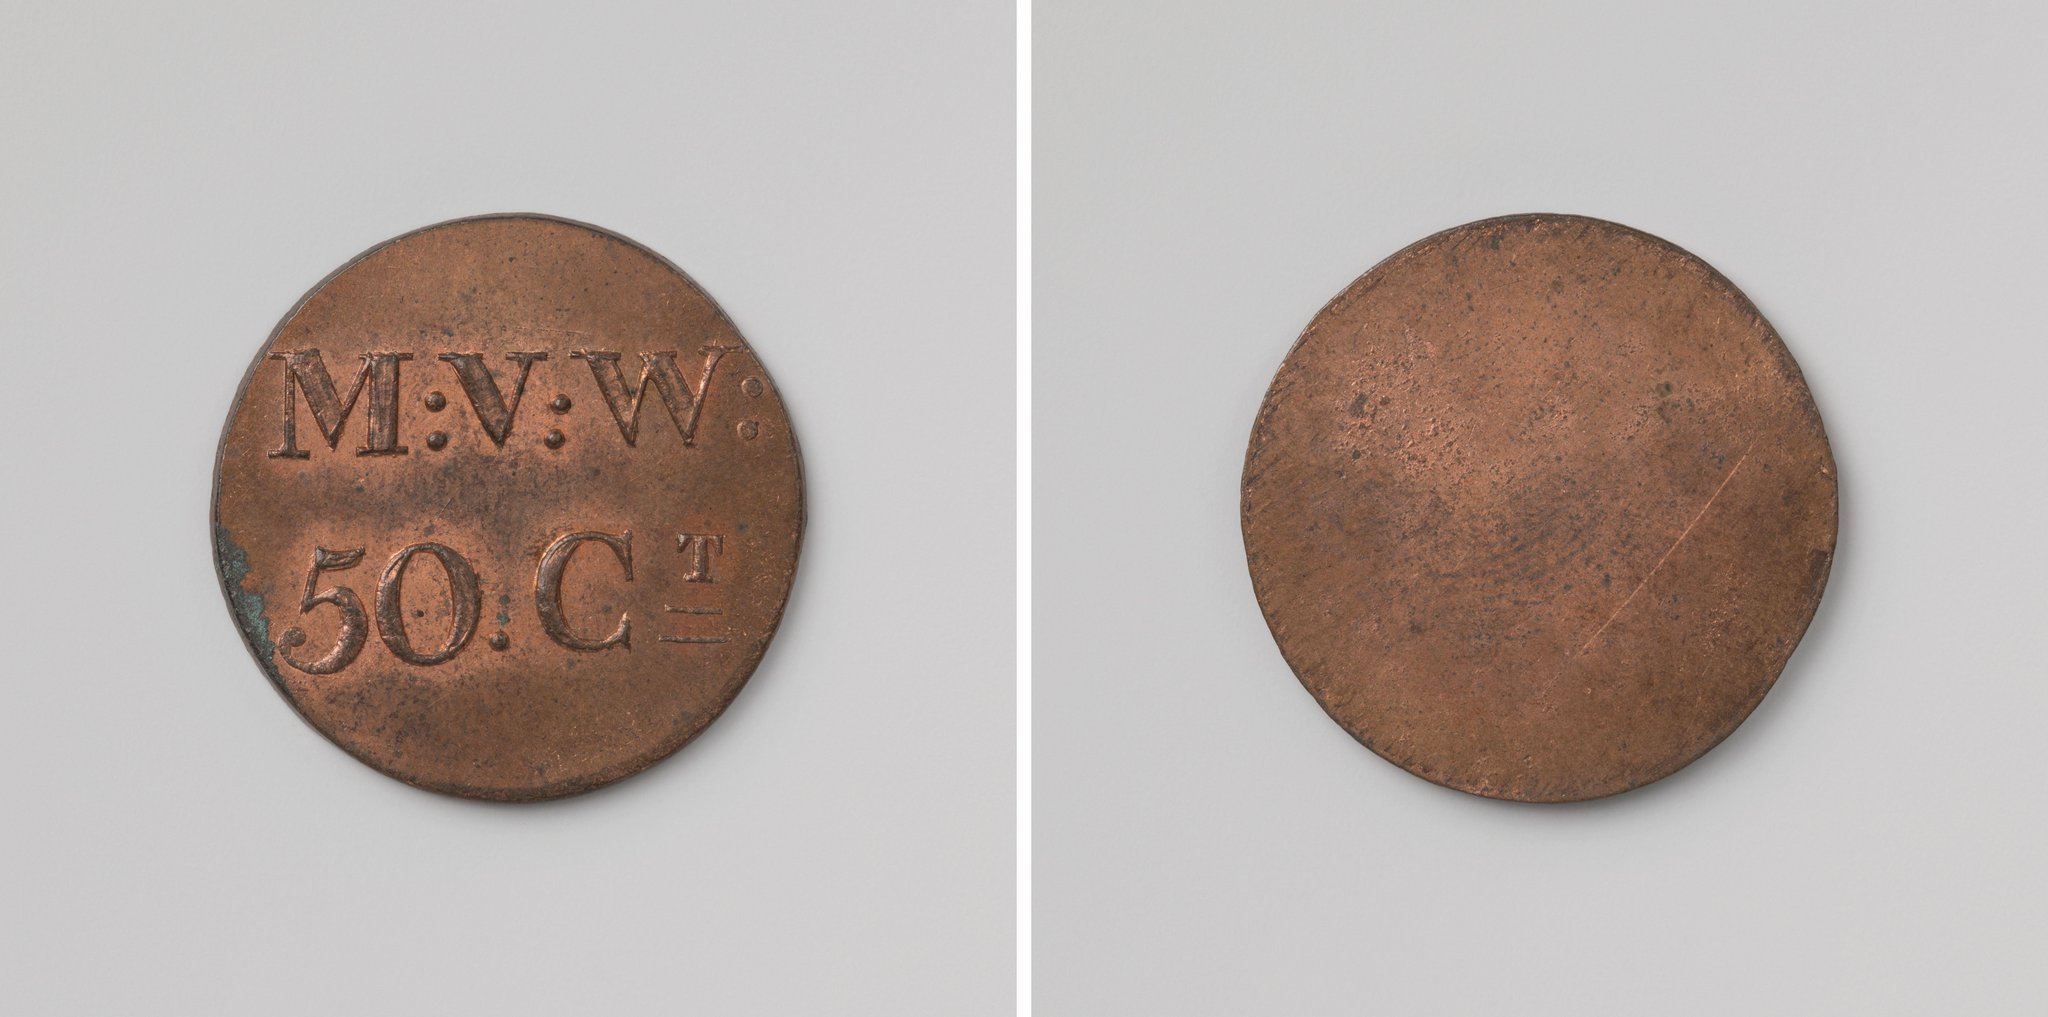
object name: vijftig cent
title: Huismunt geslagen op last van de Maatschappij van Weldadigheid ter waarde van 50 cent, ten behoeve van de Gewone Koloniën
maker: Anonymous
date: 1818-1859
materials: copper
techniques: striking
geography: netherlands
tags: maatschappij van weldadigheid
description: eenzijdige munt. Voorzijde: opschrift boven waardeaanduiding. Keerzijde: blanco